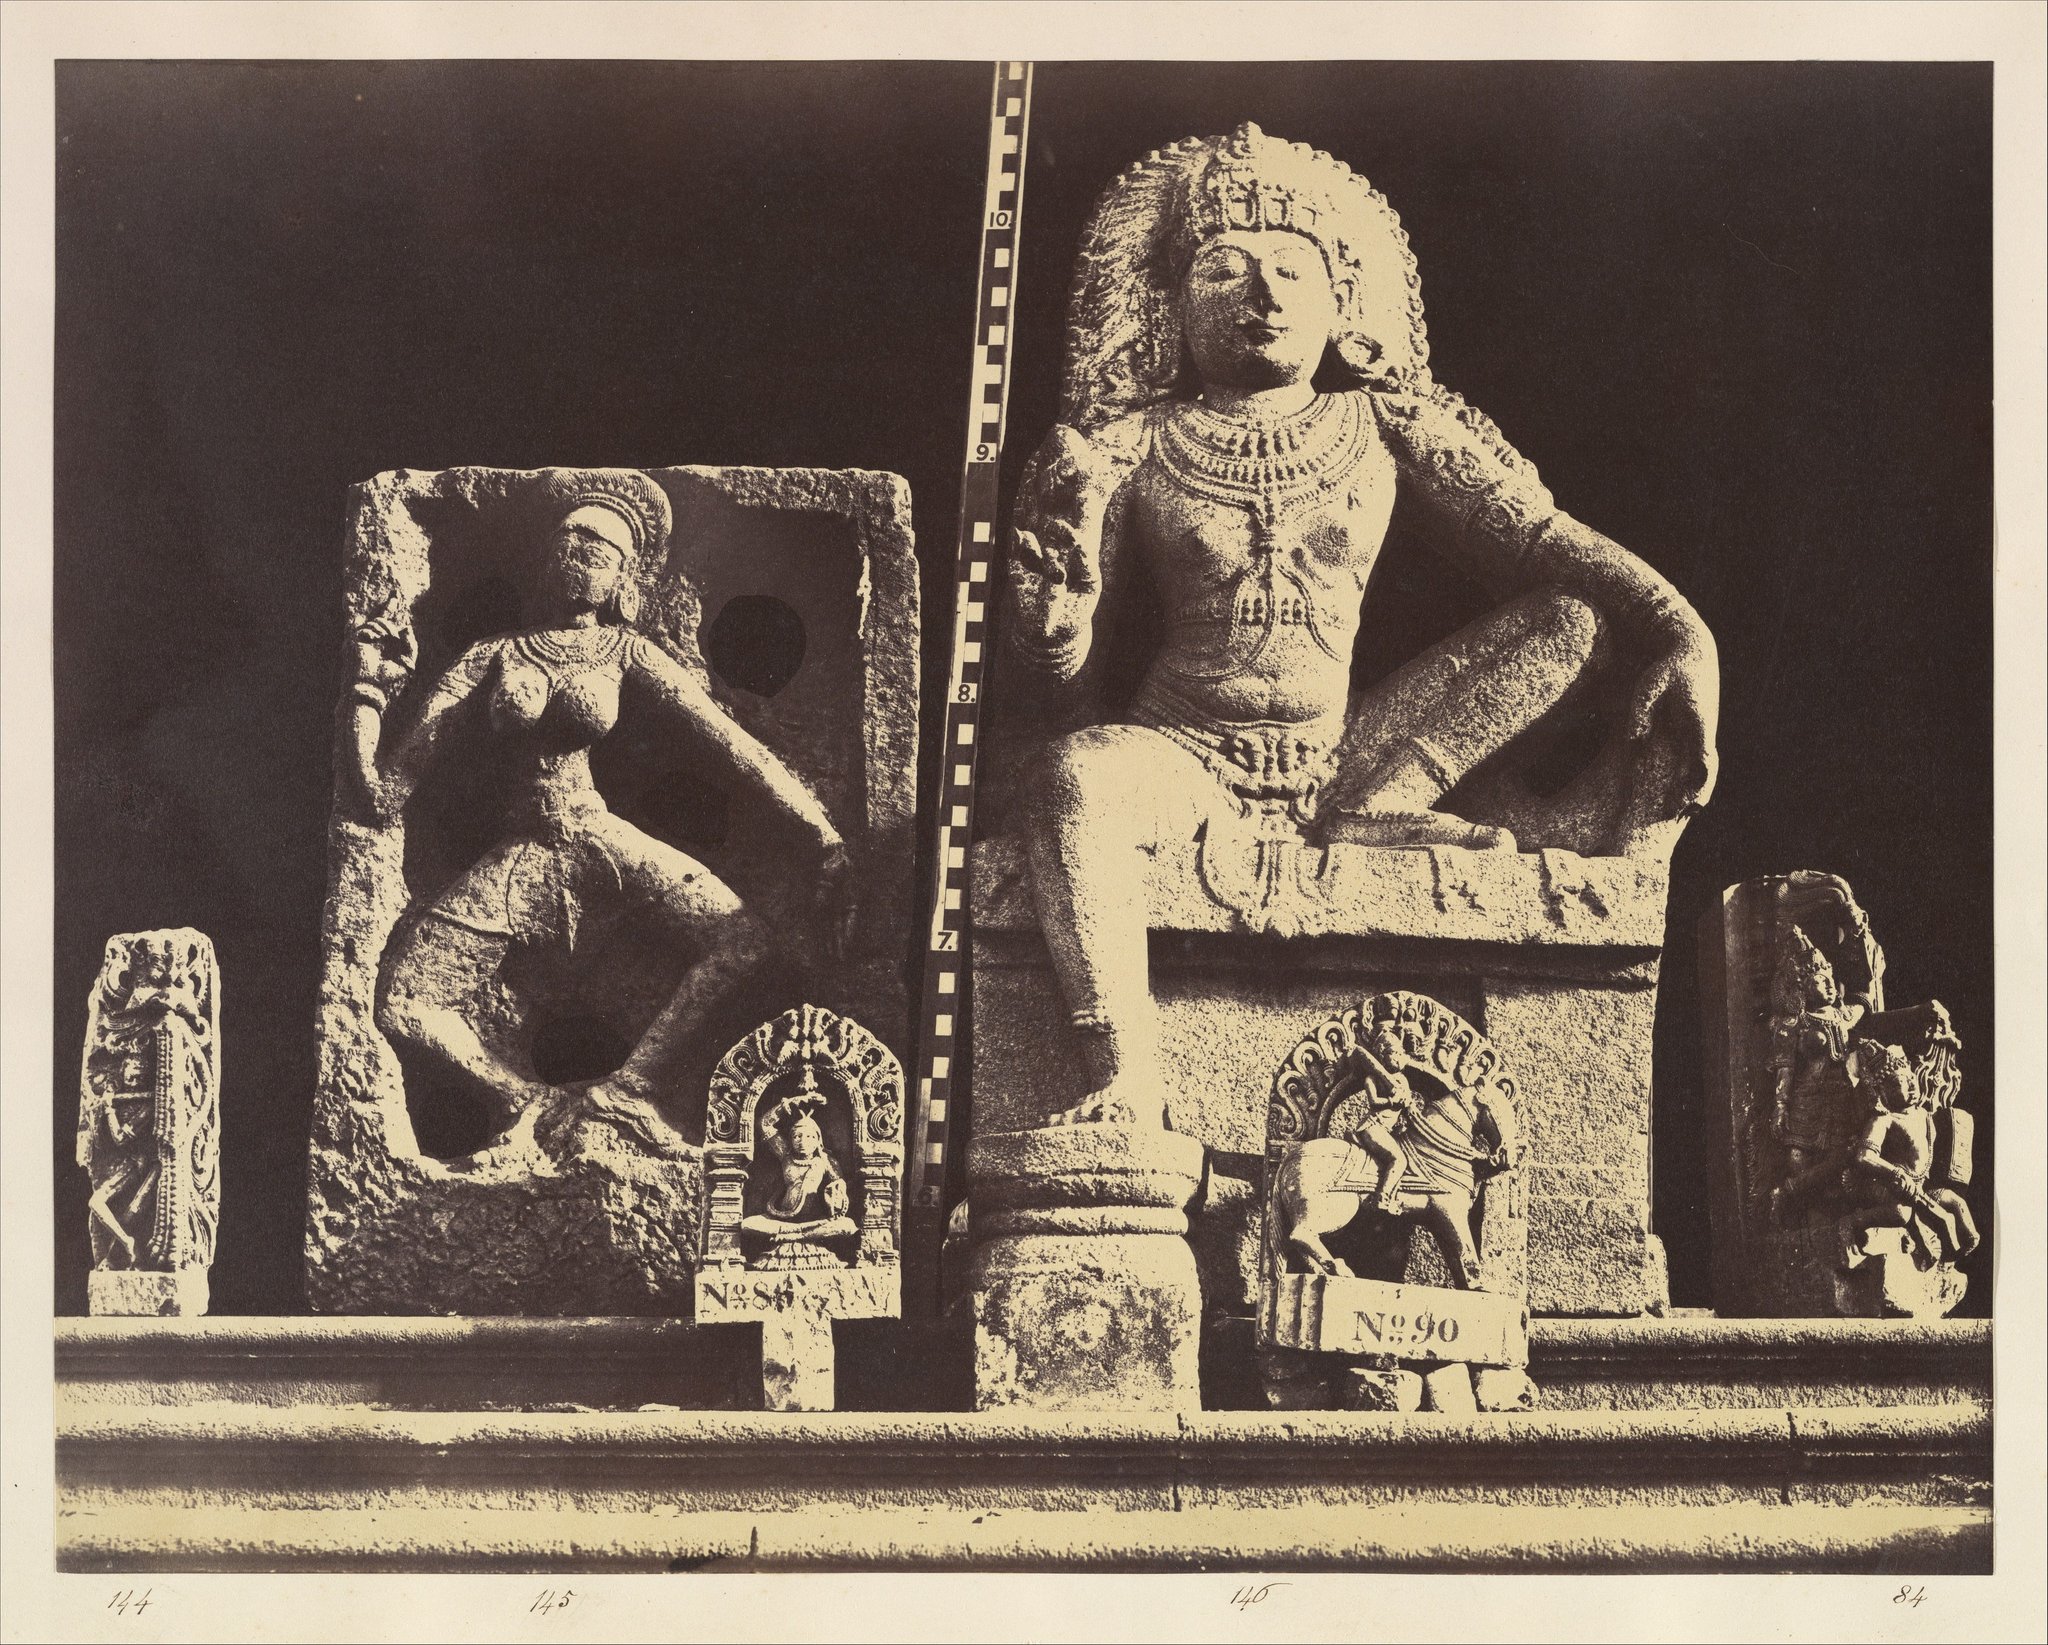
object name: photograph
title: Elliot Marbles and Other Sculpture from the Central Museum Madras: Group 26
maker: linnaeus tripe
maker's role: artist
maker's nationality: british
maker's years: 1822-1902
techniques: albumen silver print, glass negative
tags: sculpture